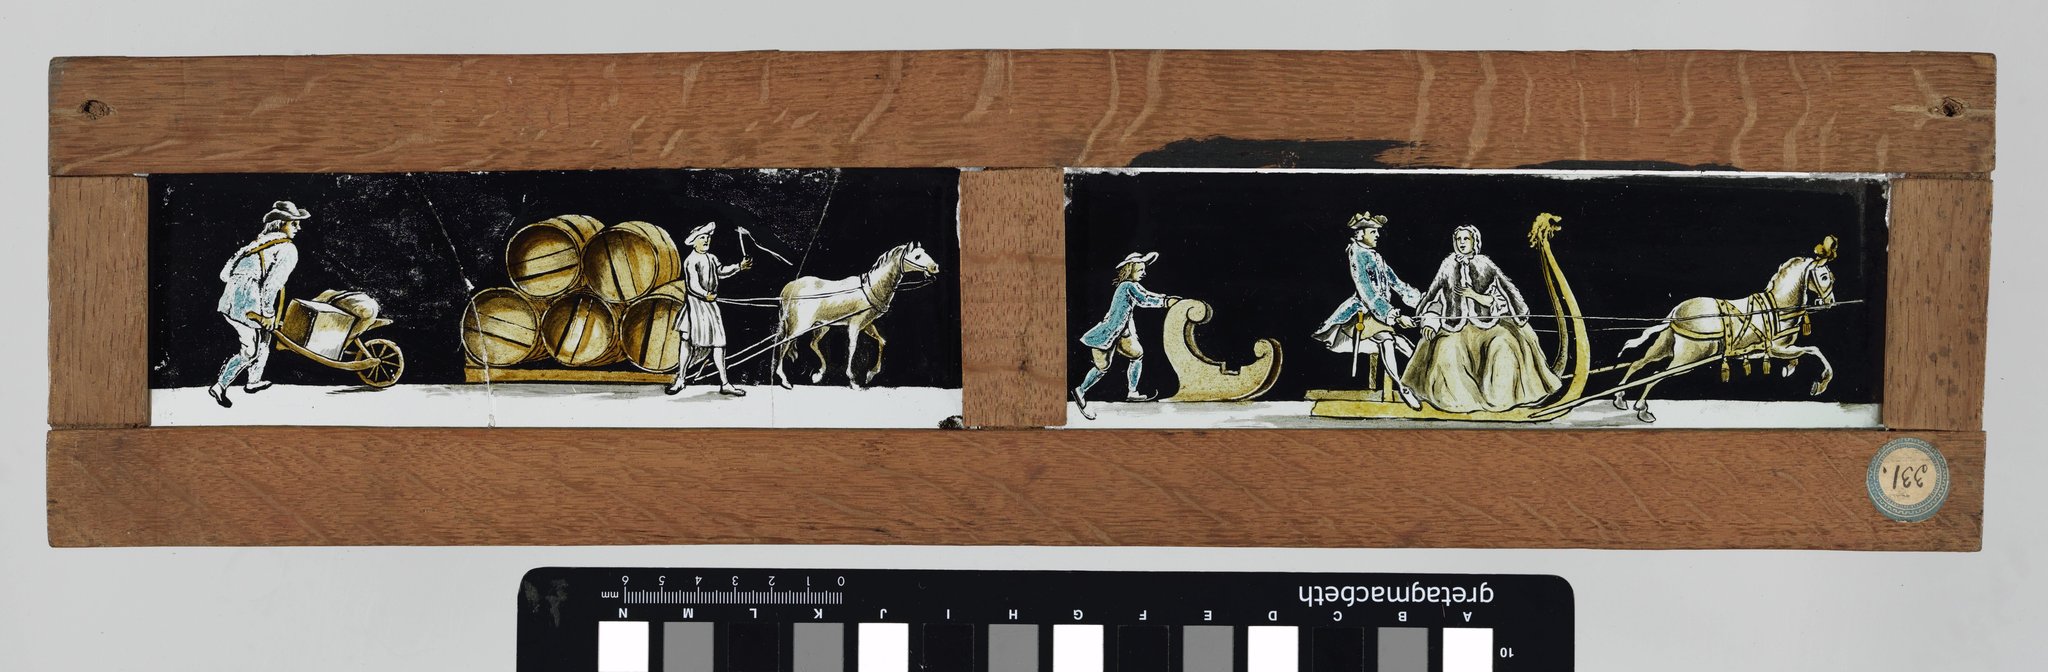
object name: lantern slide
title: Twee sledes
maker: Anonymous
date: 1700-1790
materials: glass, wood, oil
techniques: painted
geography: netherlands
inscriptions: label: ‘'Gebrandschilderde glazen. Collectie I.S. van der Schaaff, Baarn. No. 22 (twee en twintig) inhoudende twee glazen, voorstellende twee oud Hollandsche wintertaferelen. Eén glas geheel ongeschonden en heel, terwijl één glas twee barsten heeft op 4 maart 1886.'’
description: Twee panoramaglazen in een houten vatting. Links: een paard trekt een platte slee geladen met grote tonnen. Achter de slee een man met kruiwagen. Rechts: een man en vrouw op een door één paard getrokken slee. Achter hen een schaatsende jongen achter een kleinere slee.